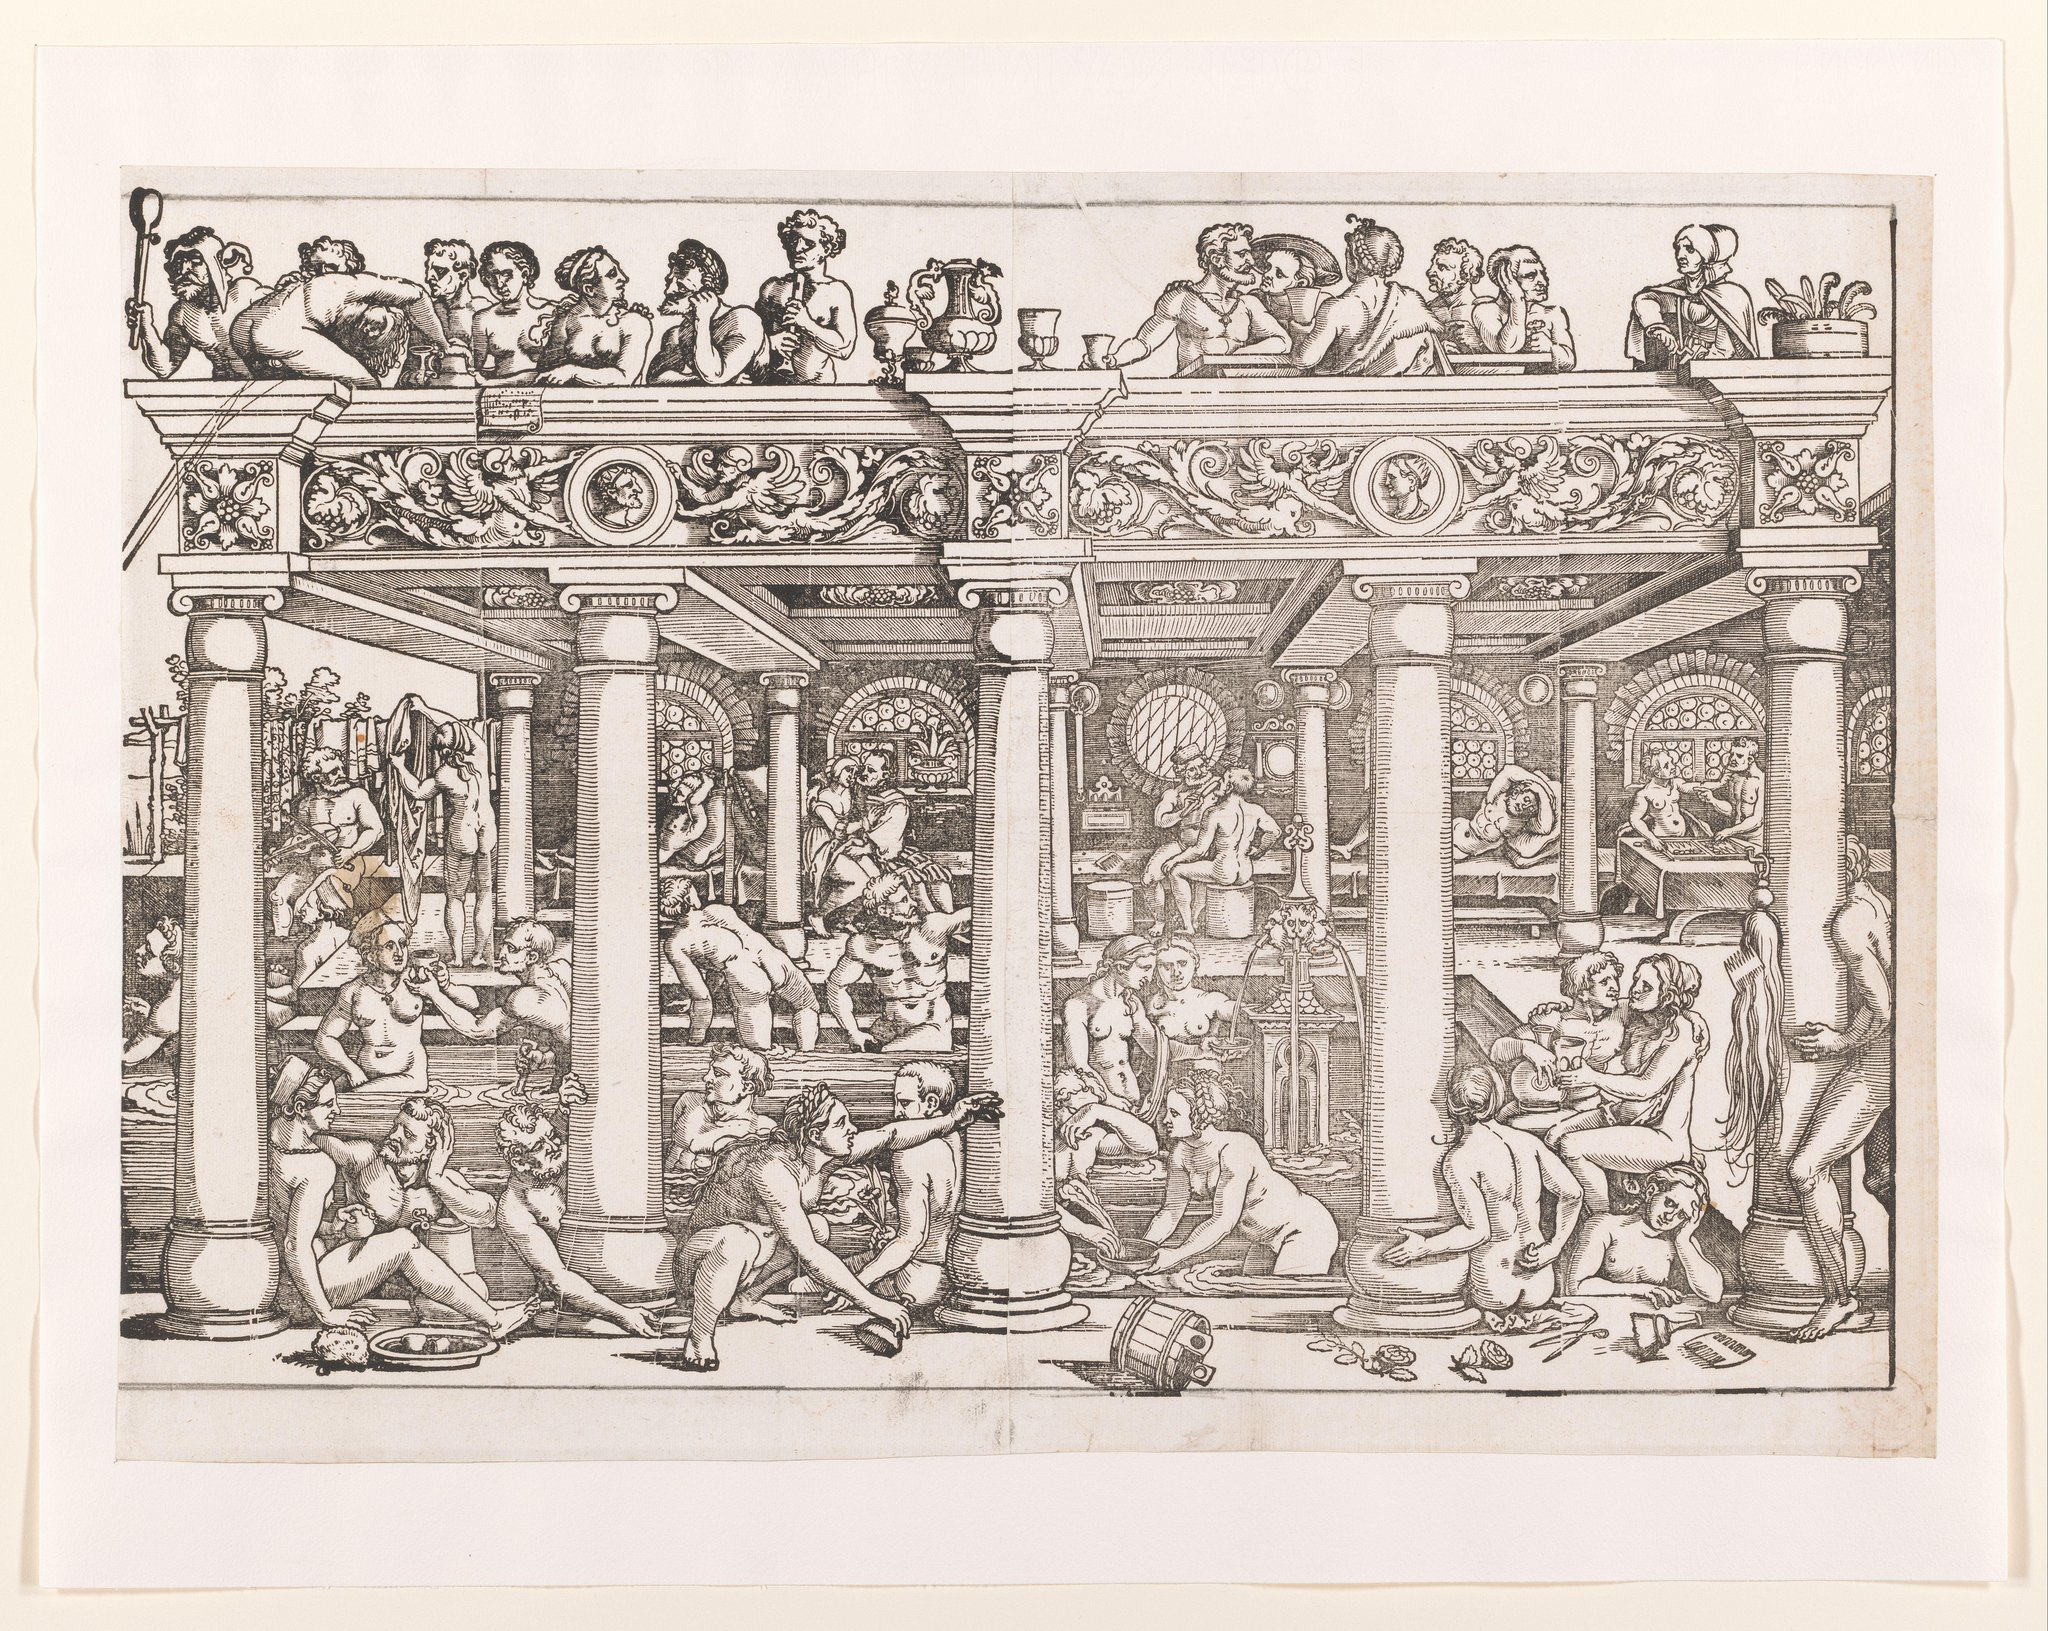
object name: print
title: Fontein van de jeugd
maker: Anonymous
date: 1510-1550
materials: paper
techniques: woodcut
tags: fountain of love, 'fons amoris', fountain of youth, 'fontaine de jouvence'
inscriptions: collector's mark: Lugt 2228, collector's mark: Lugt 240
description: Rechter deel bestaande uit twee blokken van een geheel van vier blokken.